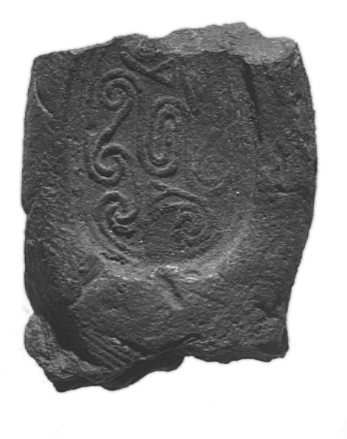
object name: sealing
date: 2030-1640 BCE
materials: clay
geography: egypt